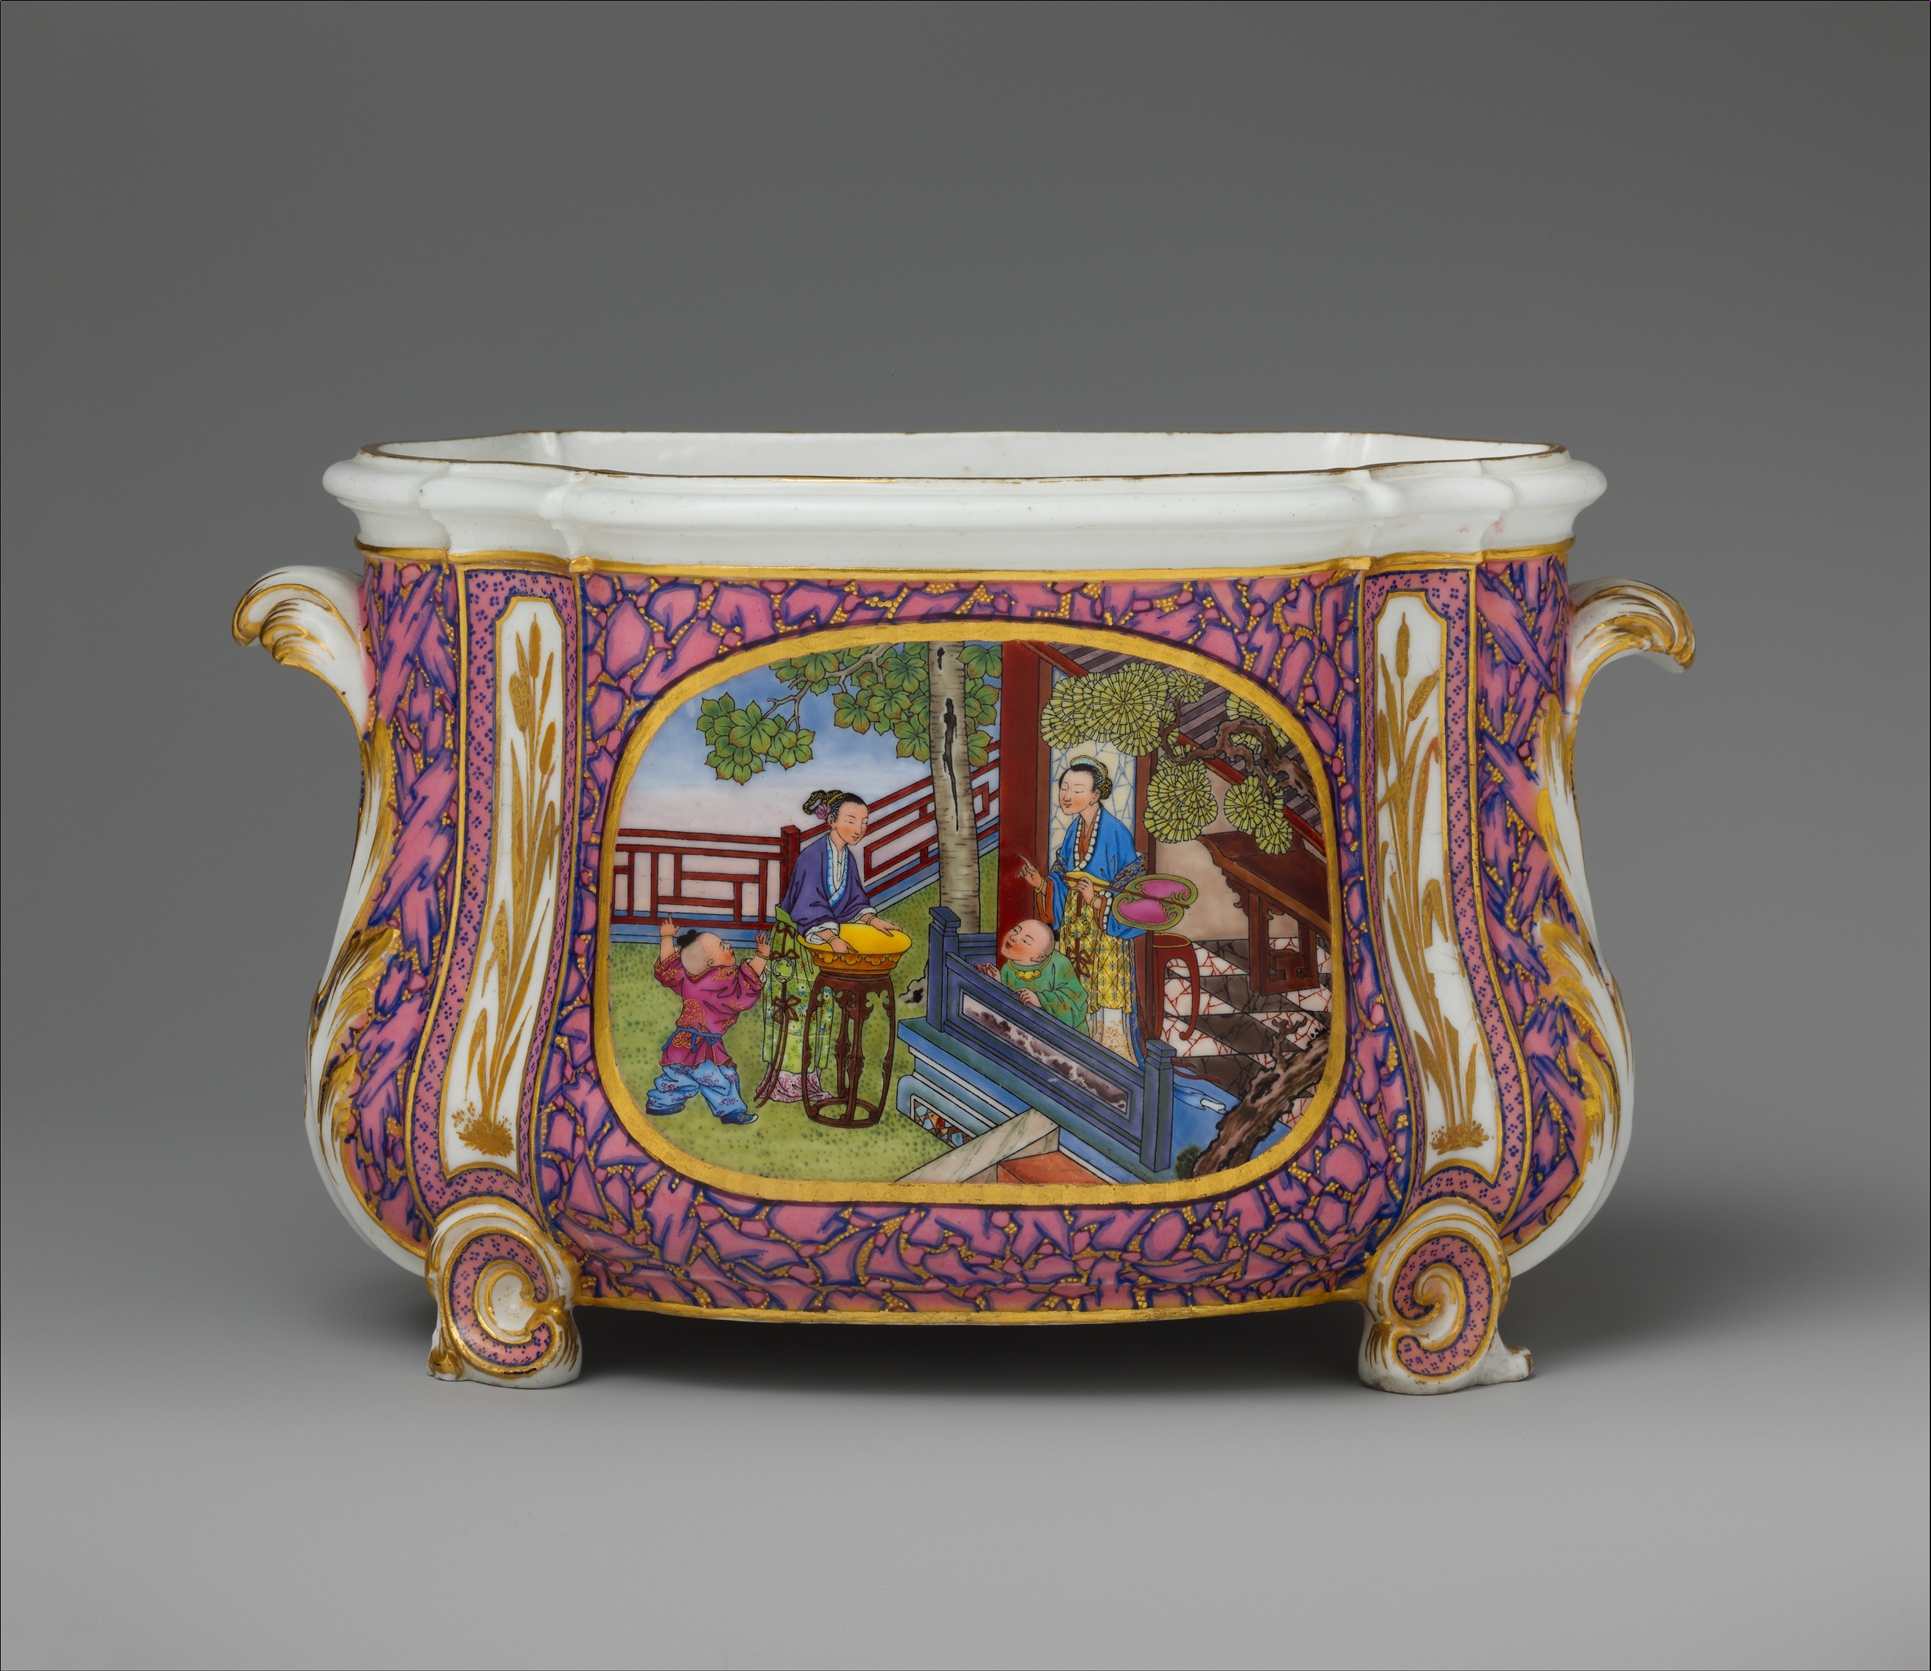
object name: vase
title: Vase (cuvette à fleurs Courteille)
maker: sèvres manufactory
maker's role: manufactory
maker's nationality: french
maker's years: 1740-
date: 1762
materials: enamel, gold, soft paste porcelain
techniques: polychrome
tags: chinoiserie,children,women